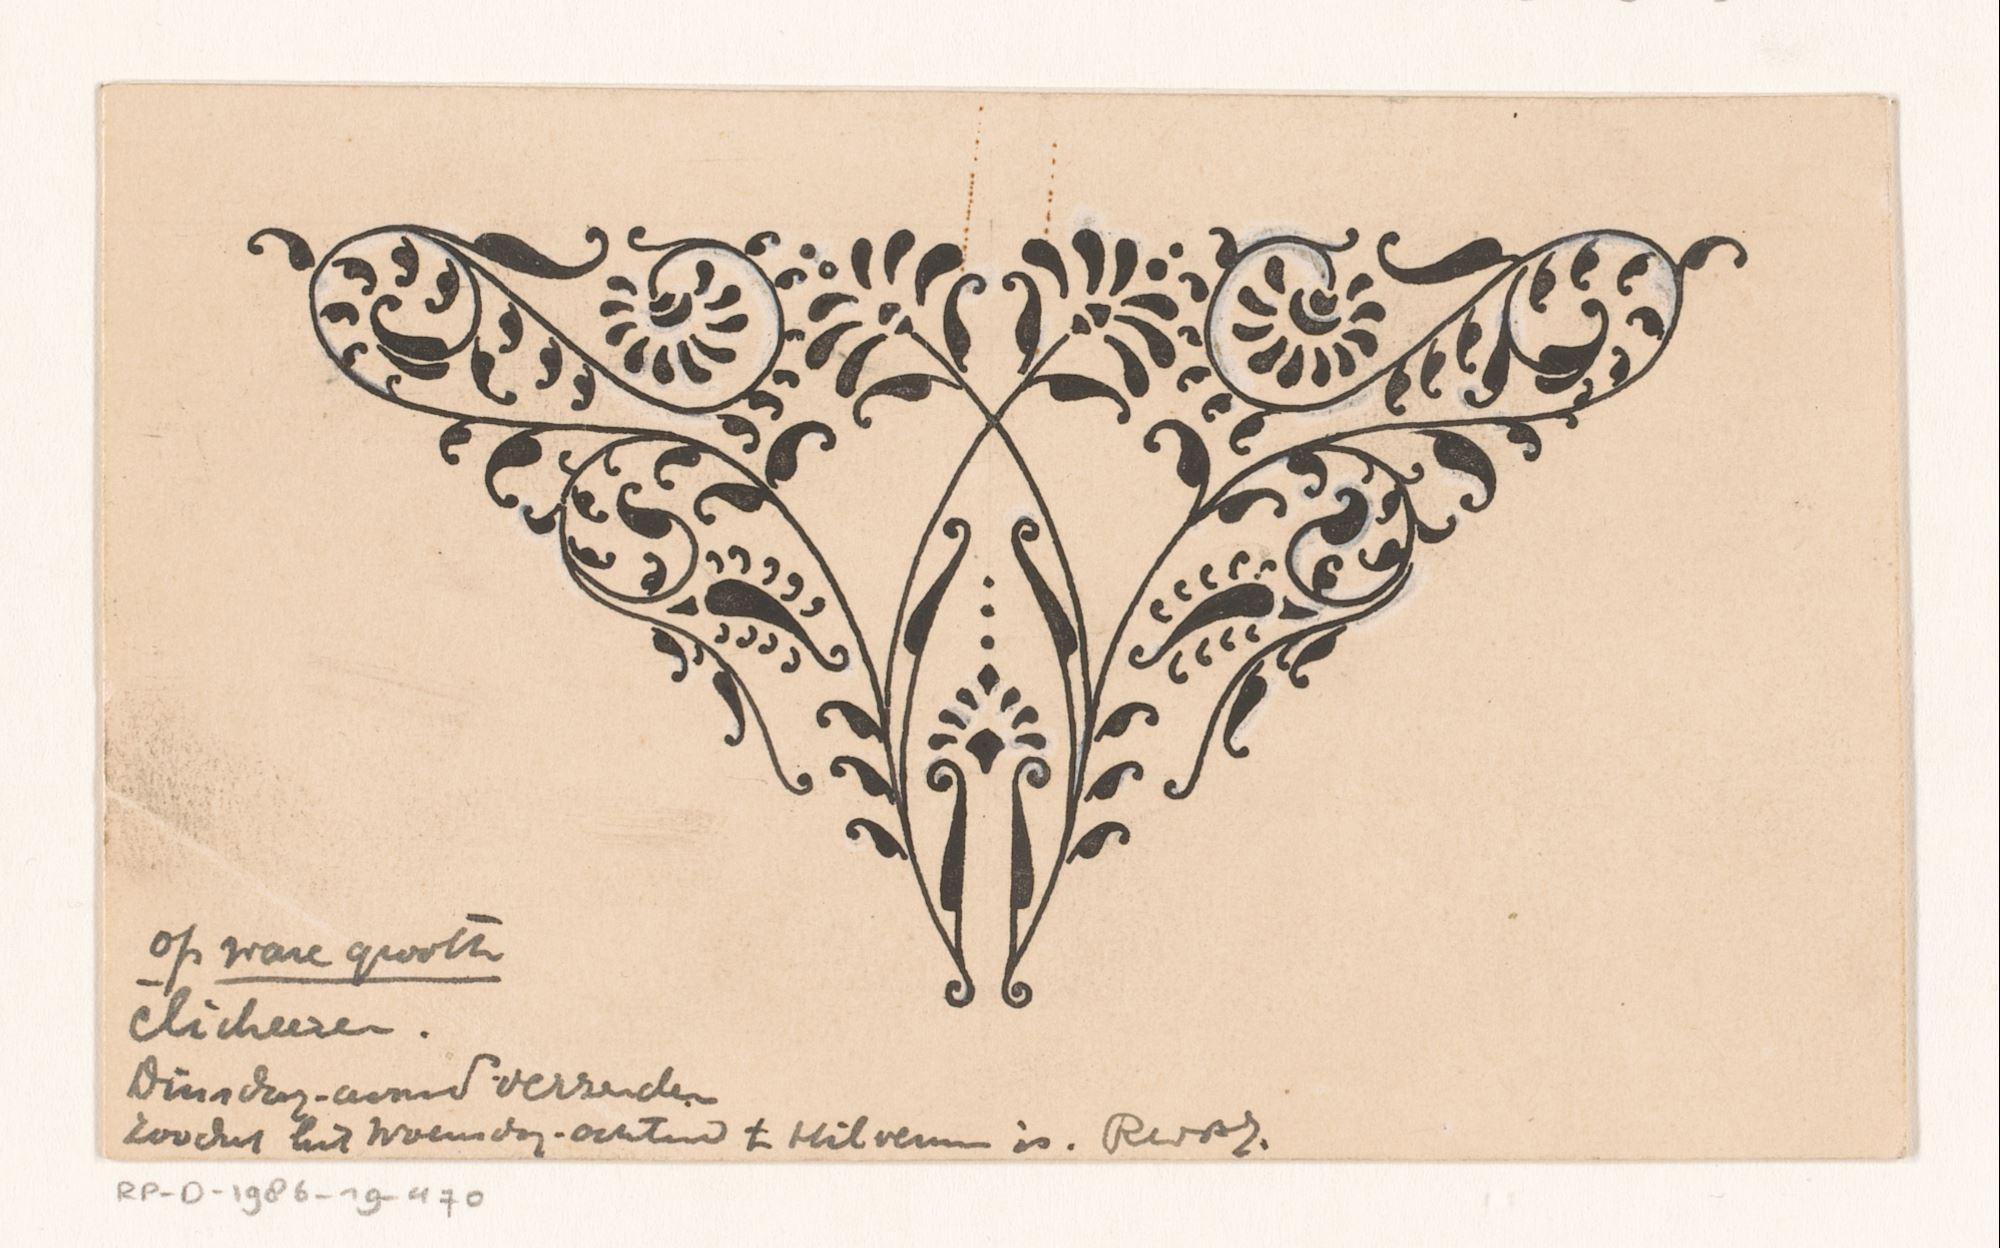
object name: drawing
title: Driehoekig vignet met bladmotief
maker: reinier willem petrus de vries (1874-1953)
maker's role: draughtsman, print maker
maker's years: 1874-1953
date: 1884-1952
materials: paint, ink, paper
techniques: pen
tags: foliage, tendrils, branches ~ ornament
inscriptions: collector's mark: ‘R:MVS.’